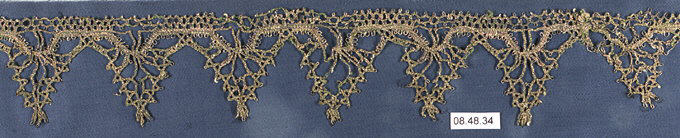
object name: fragment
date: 1550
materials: metal thread, silk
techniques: lace